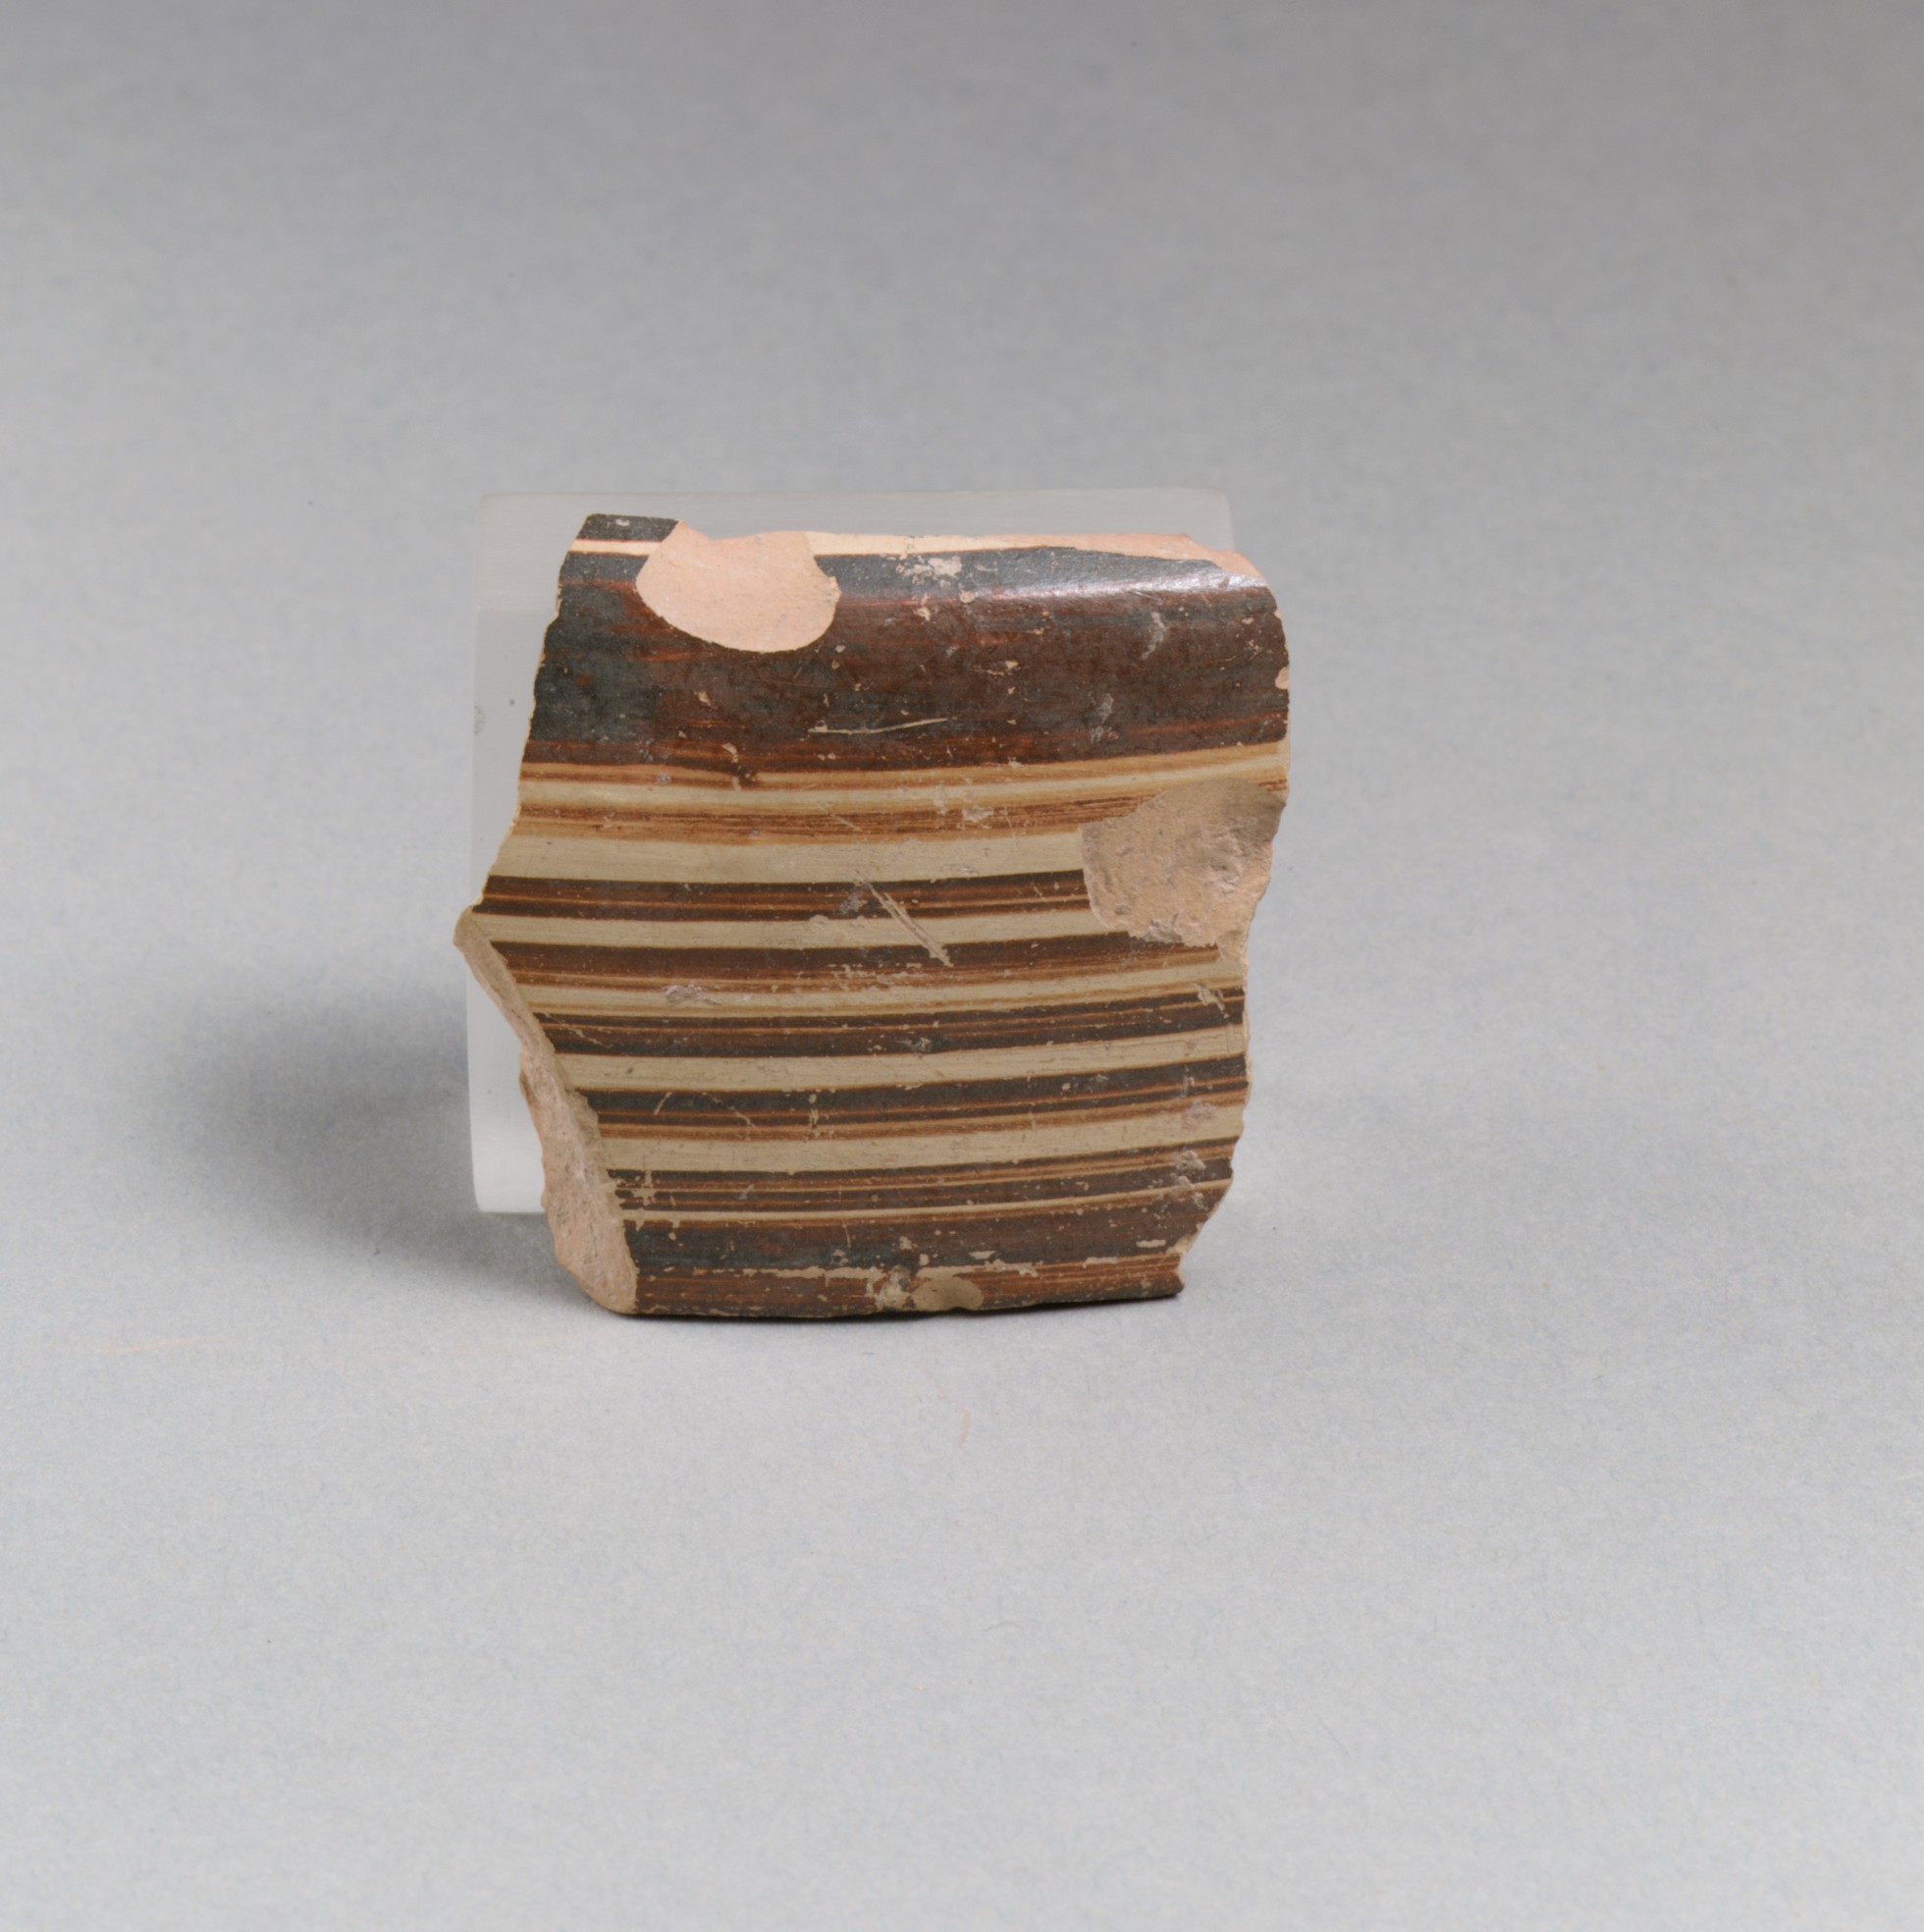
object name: vase fragment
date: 3000-2200 BCE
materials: terracotta